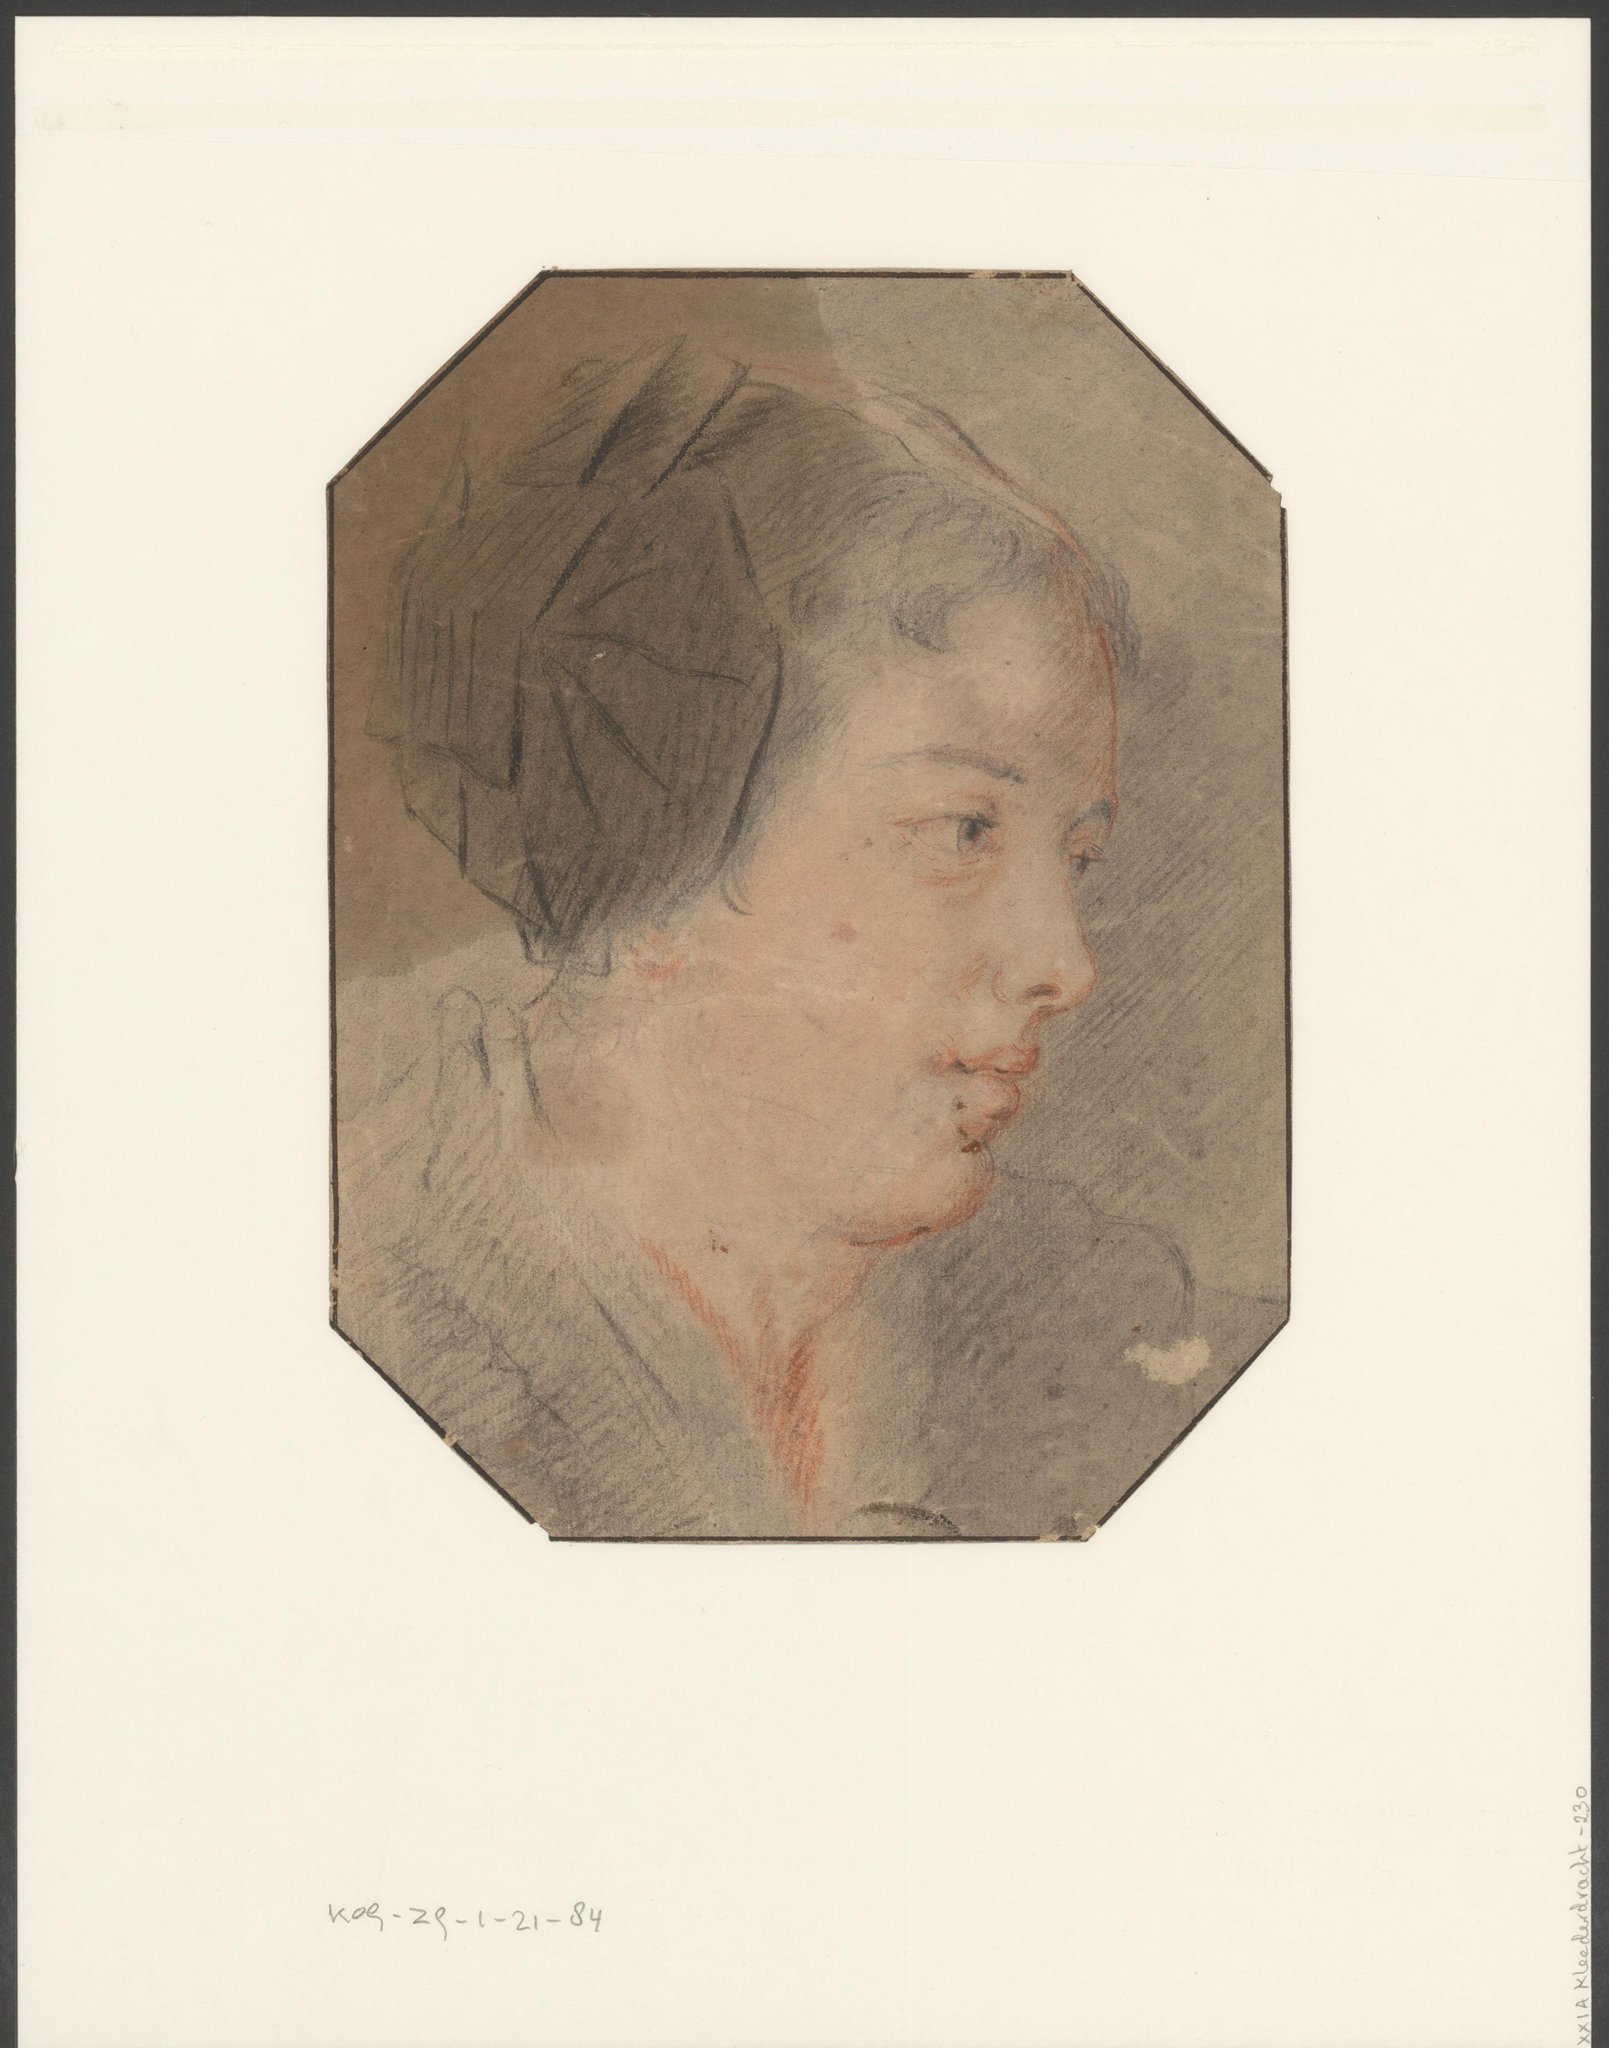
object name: drawing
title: Portret van een onbekende vrouw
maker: Anonymous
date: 1700-1799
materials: chalk, paper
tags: historical persons not known by name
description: Onderwerpsrubrieken binnen de Atlas Zeden en Gewoonten: Zeden en Gewoonten in Engeren Zin, De Kleeding, Kleederdrachten (tijdvakken), De 18de eeuw (de pruikentijd). Mannen en vrouwen.